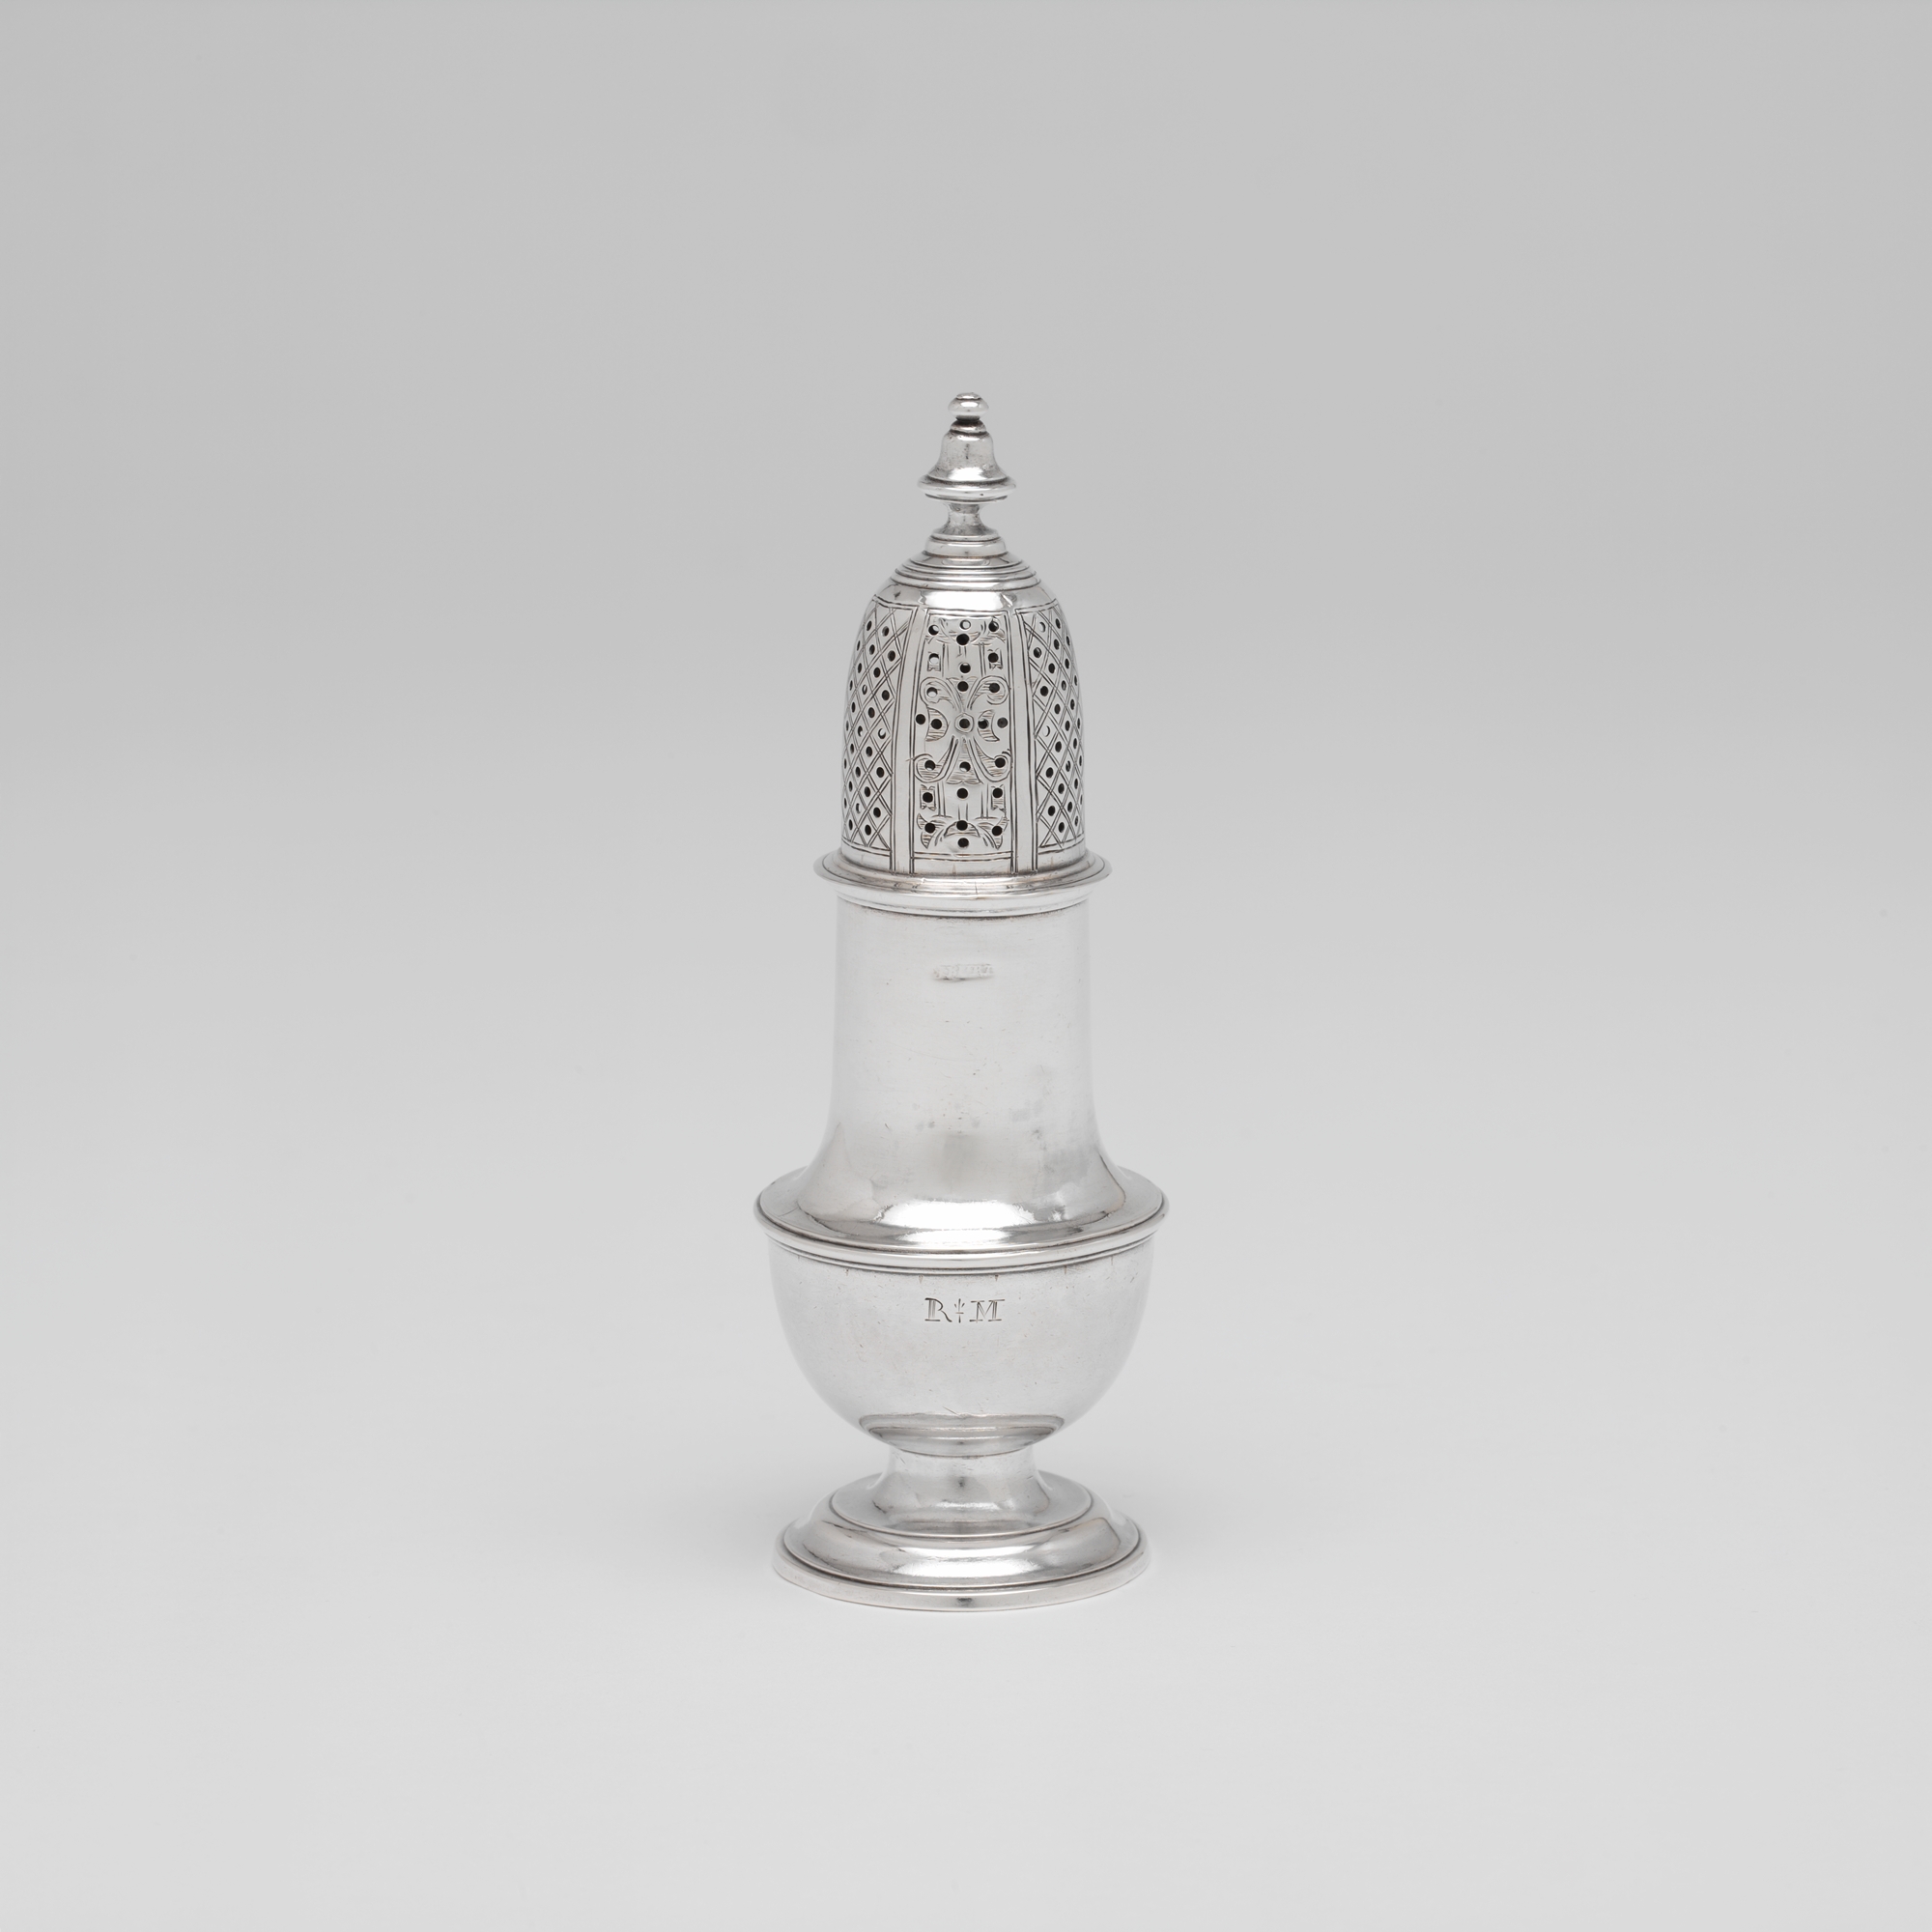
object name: caster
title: Pepper Caster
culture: american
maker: john burt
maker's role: maker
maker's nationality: american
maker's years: 1692-1746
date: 1730-1745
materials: silver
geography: united states